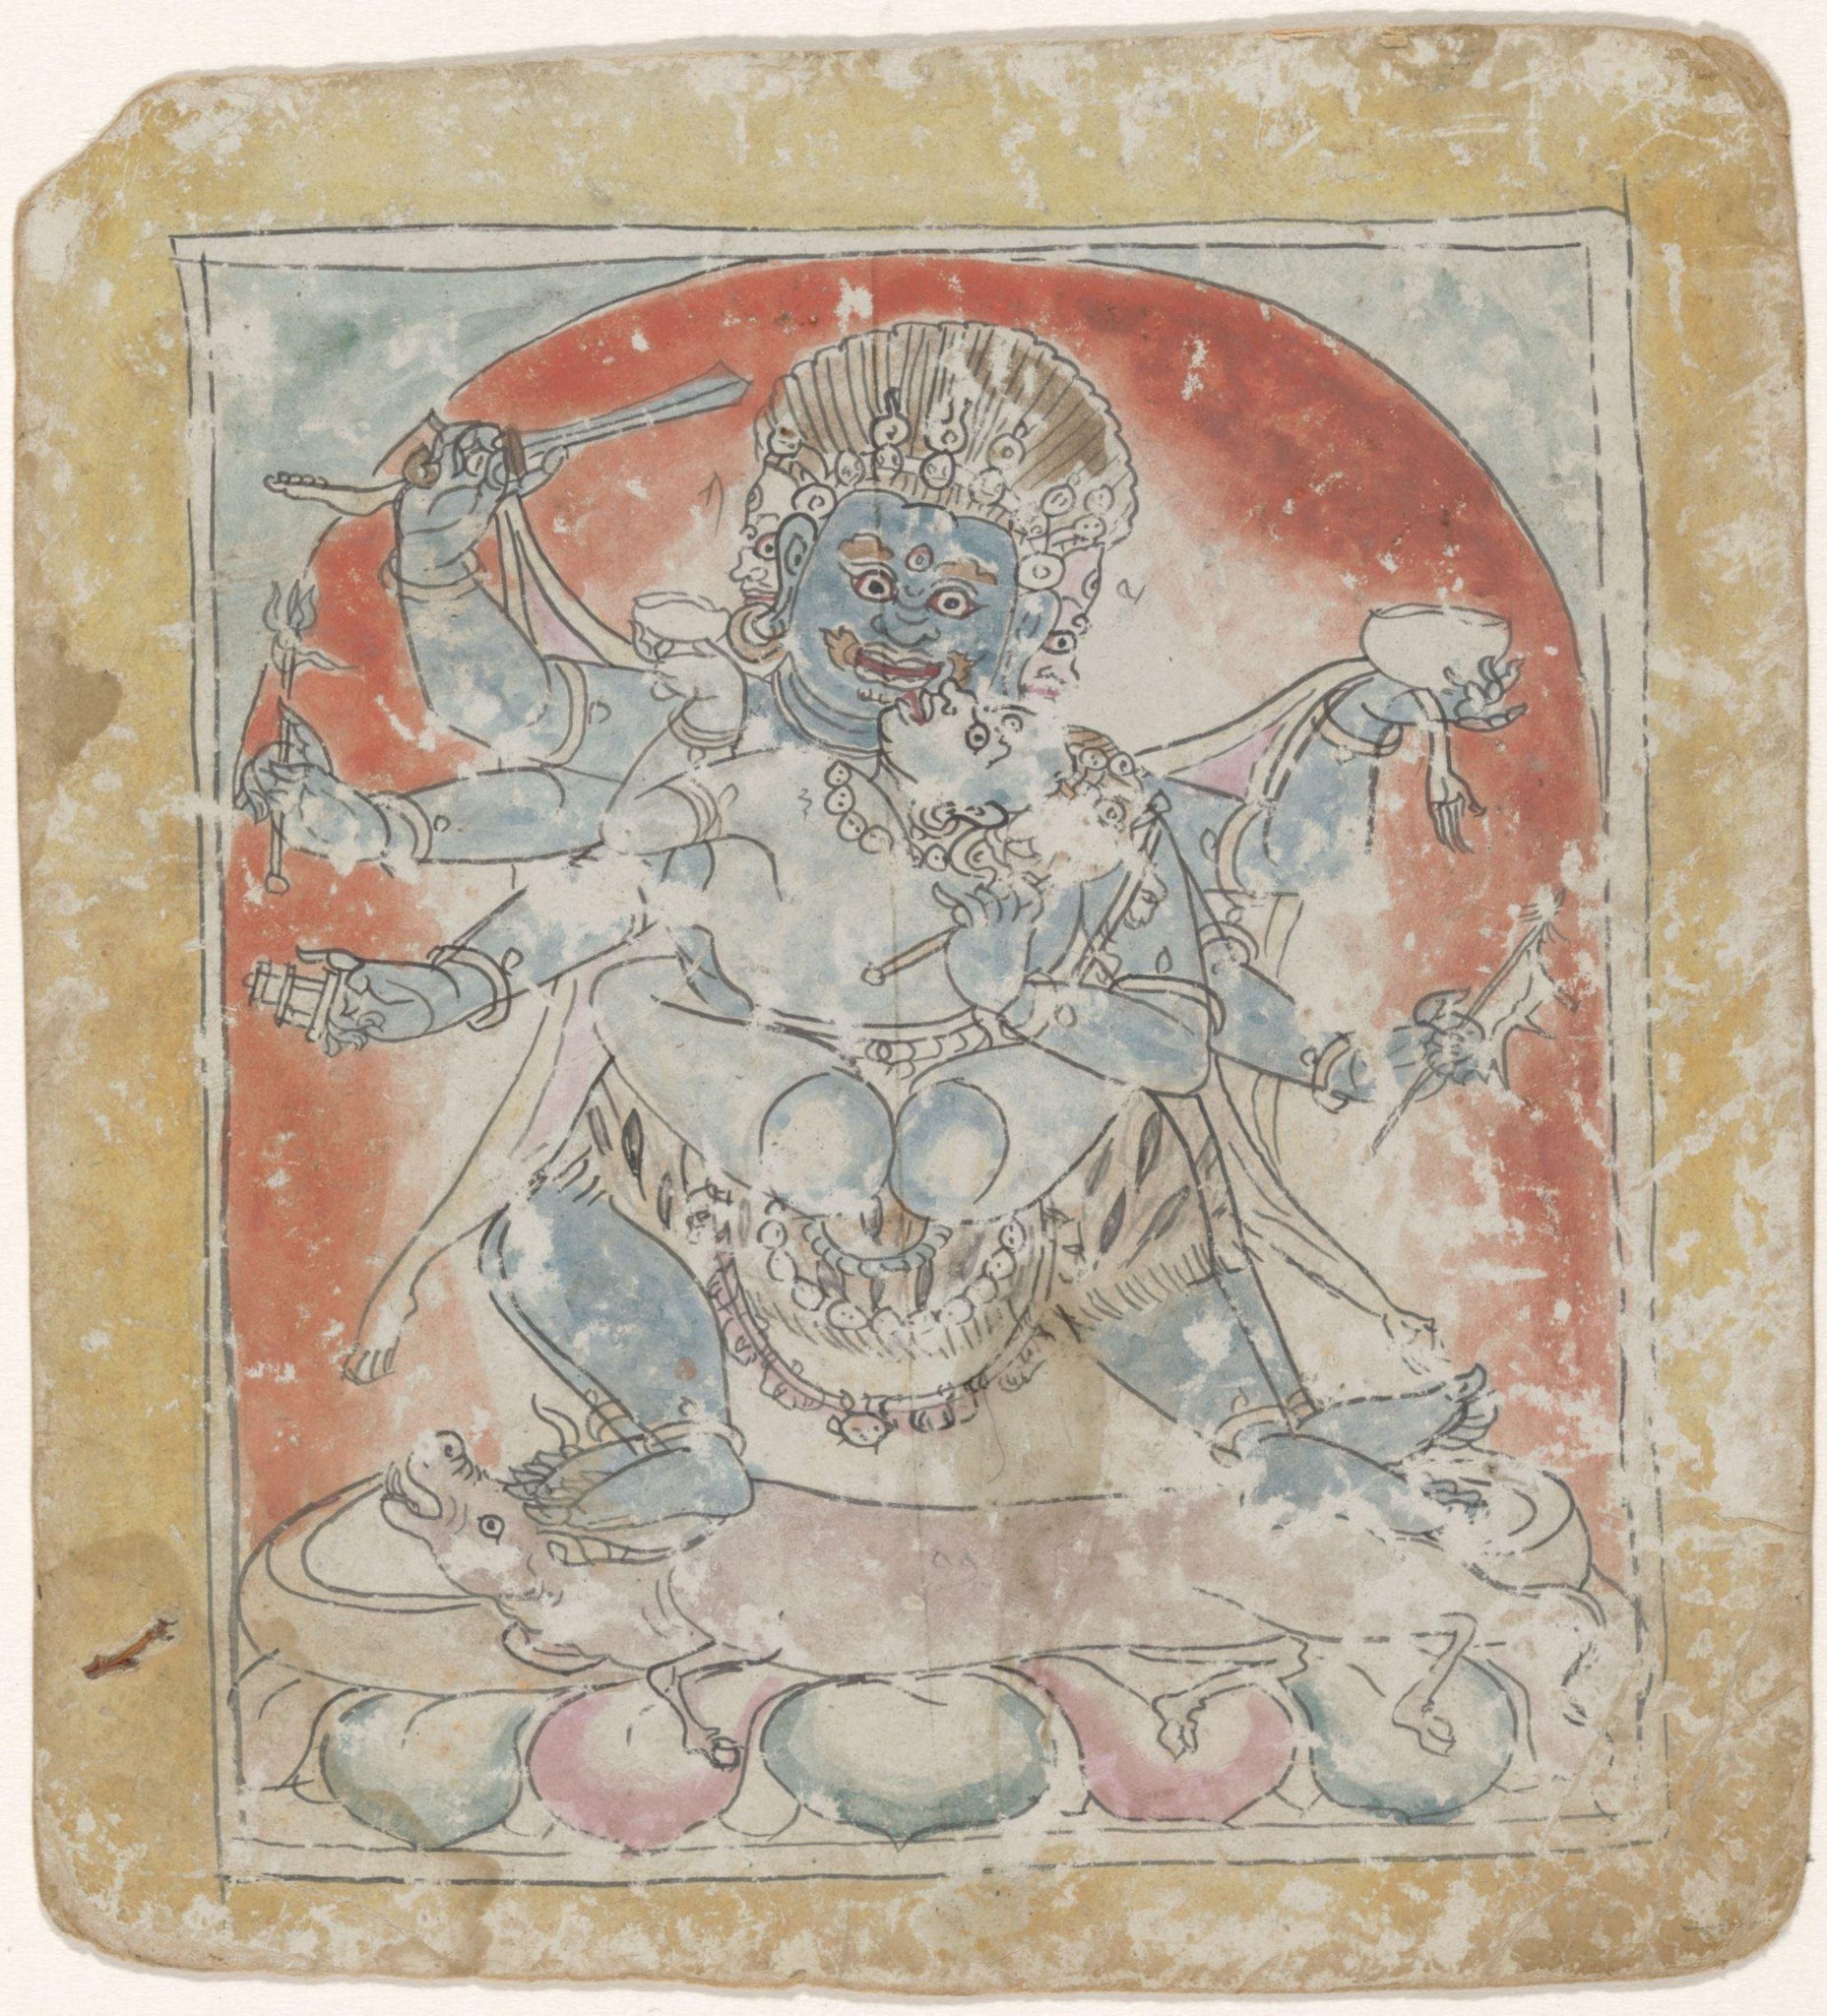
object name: drawing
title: Boeddhistische goden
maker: Anonymous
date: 1900-1970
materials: paper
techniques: brush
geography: tibet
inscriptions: inscription: ‘een paar regels calligrafie in zwart’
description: Yamantaka in vereniging met zijn partner staande op een buffel, met 6 armen, in zijn handen houdt hij diverse voorwerpen vast. Een afbeelding uit een serie van drie waarop Boeddhistische heiligen voorkomen.